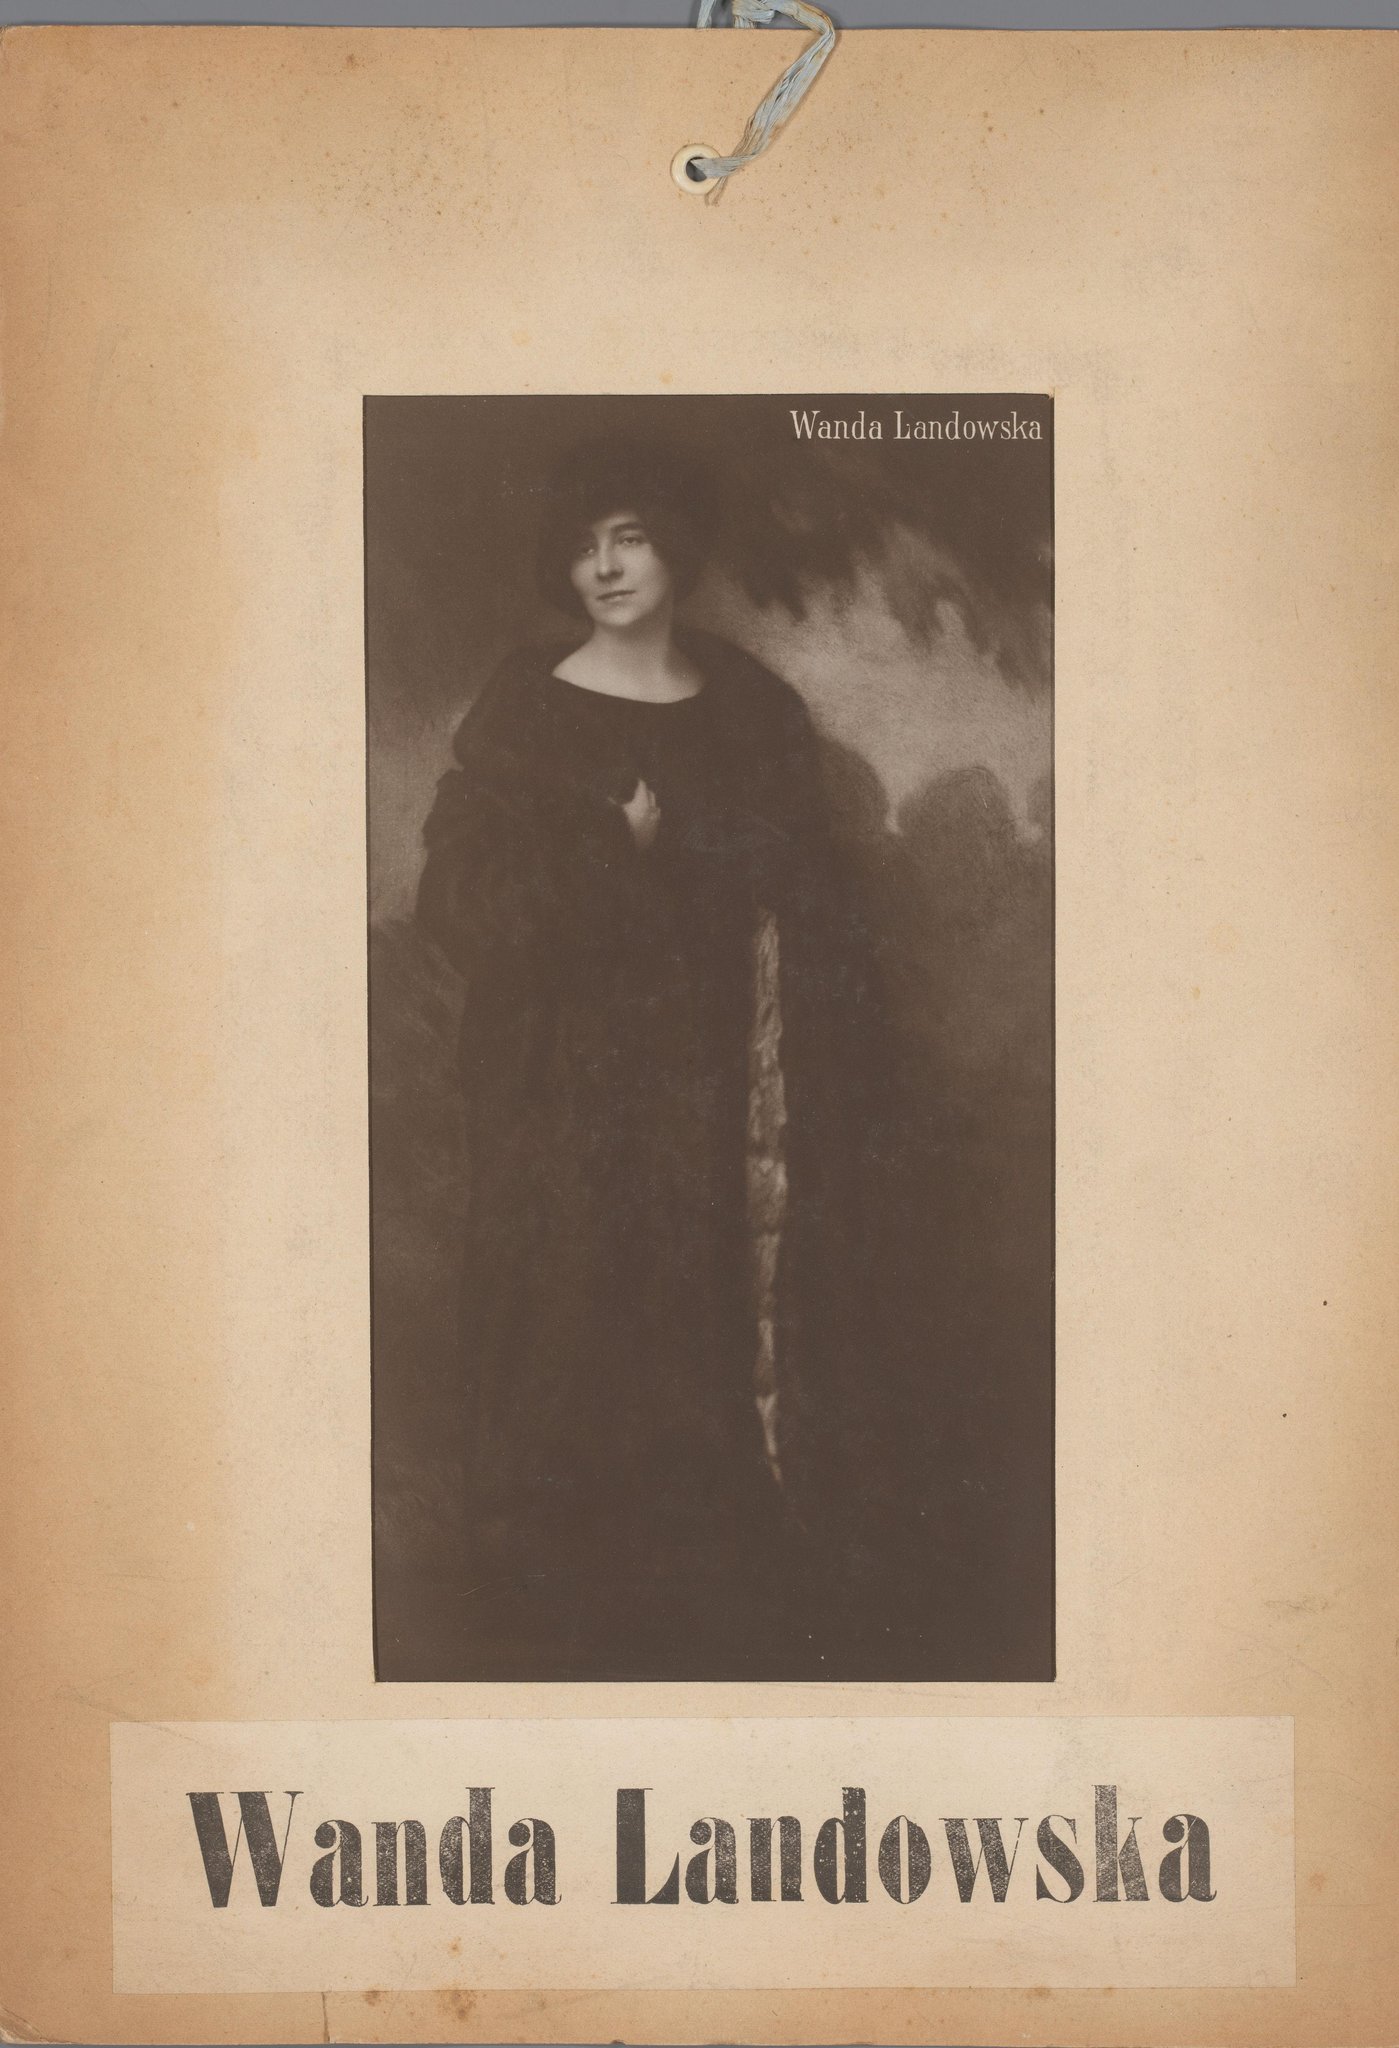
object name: photograph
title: Wanda Landowska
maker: Anonymous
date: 1900-1915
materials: paper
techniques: gelatin silver print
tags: musician, historical persons - bb - woman, portrait of a musician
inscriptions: inscription: ‘CLAVECIMBEL/ foto afkomstig [..] uit A'dam 1961’